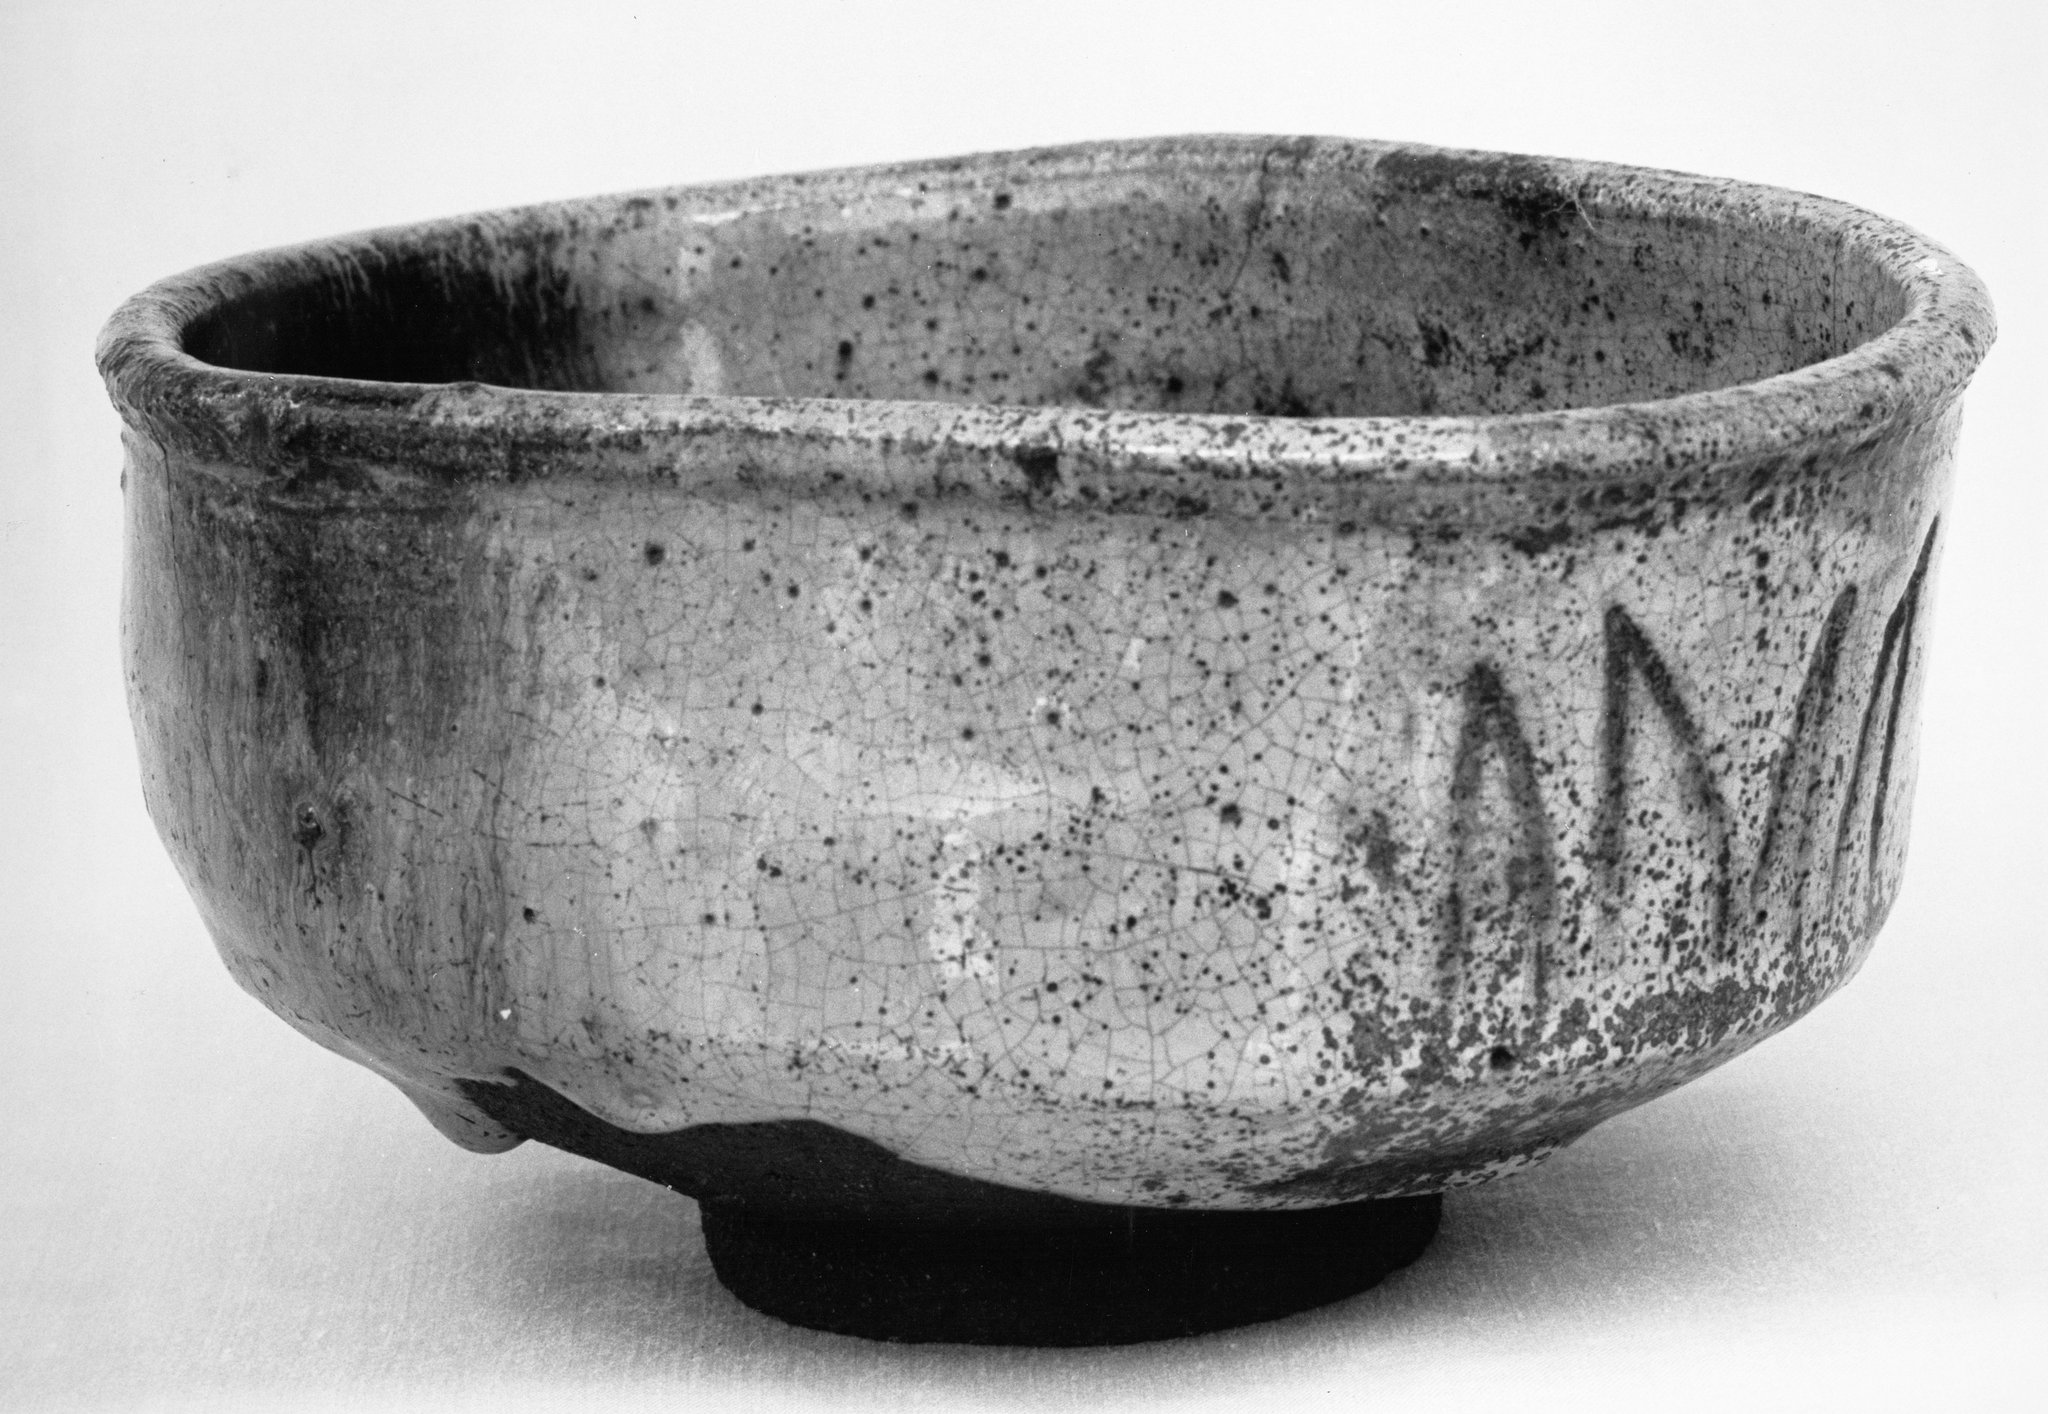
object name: teabowl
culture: japanese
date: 1667-1700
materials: wood, clay, glaze, fiber